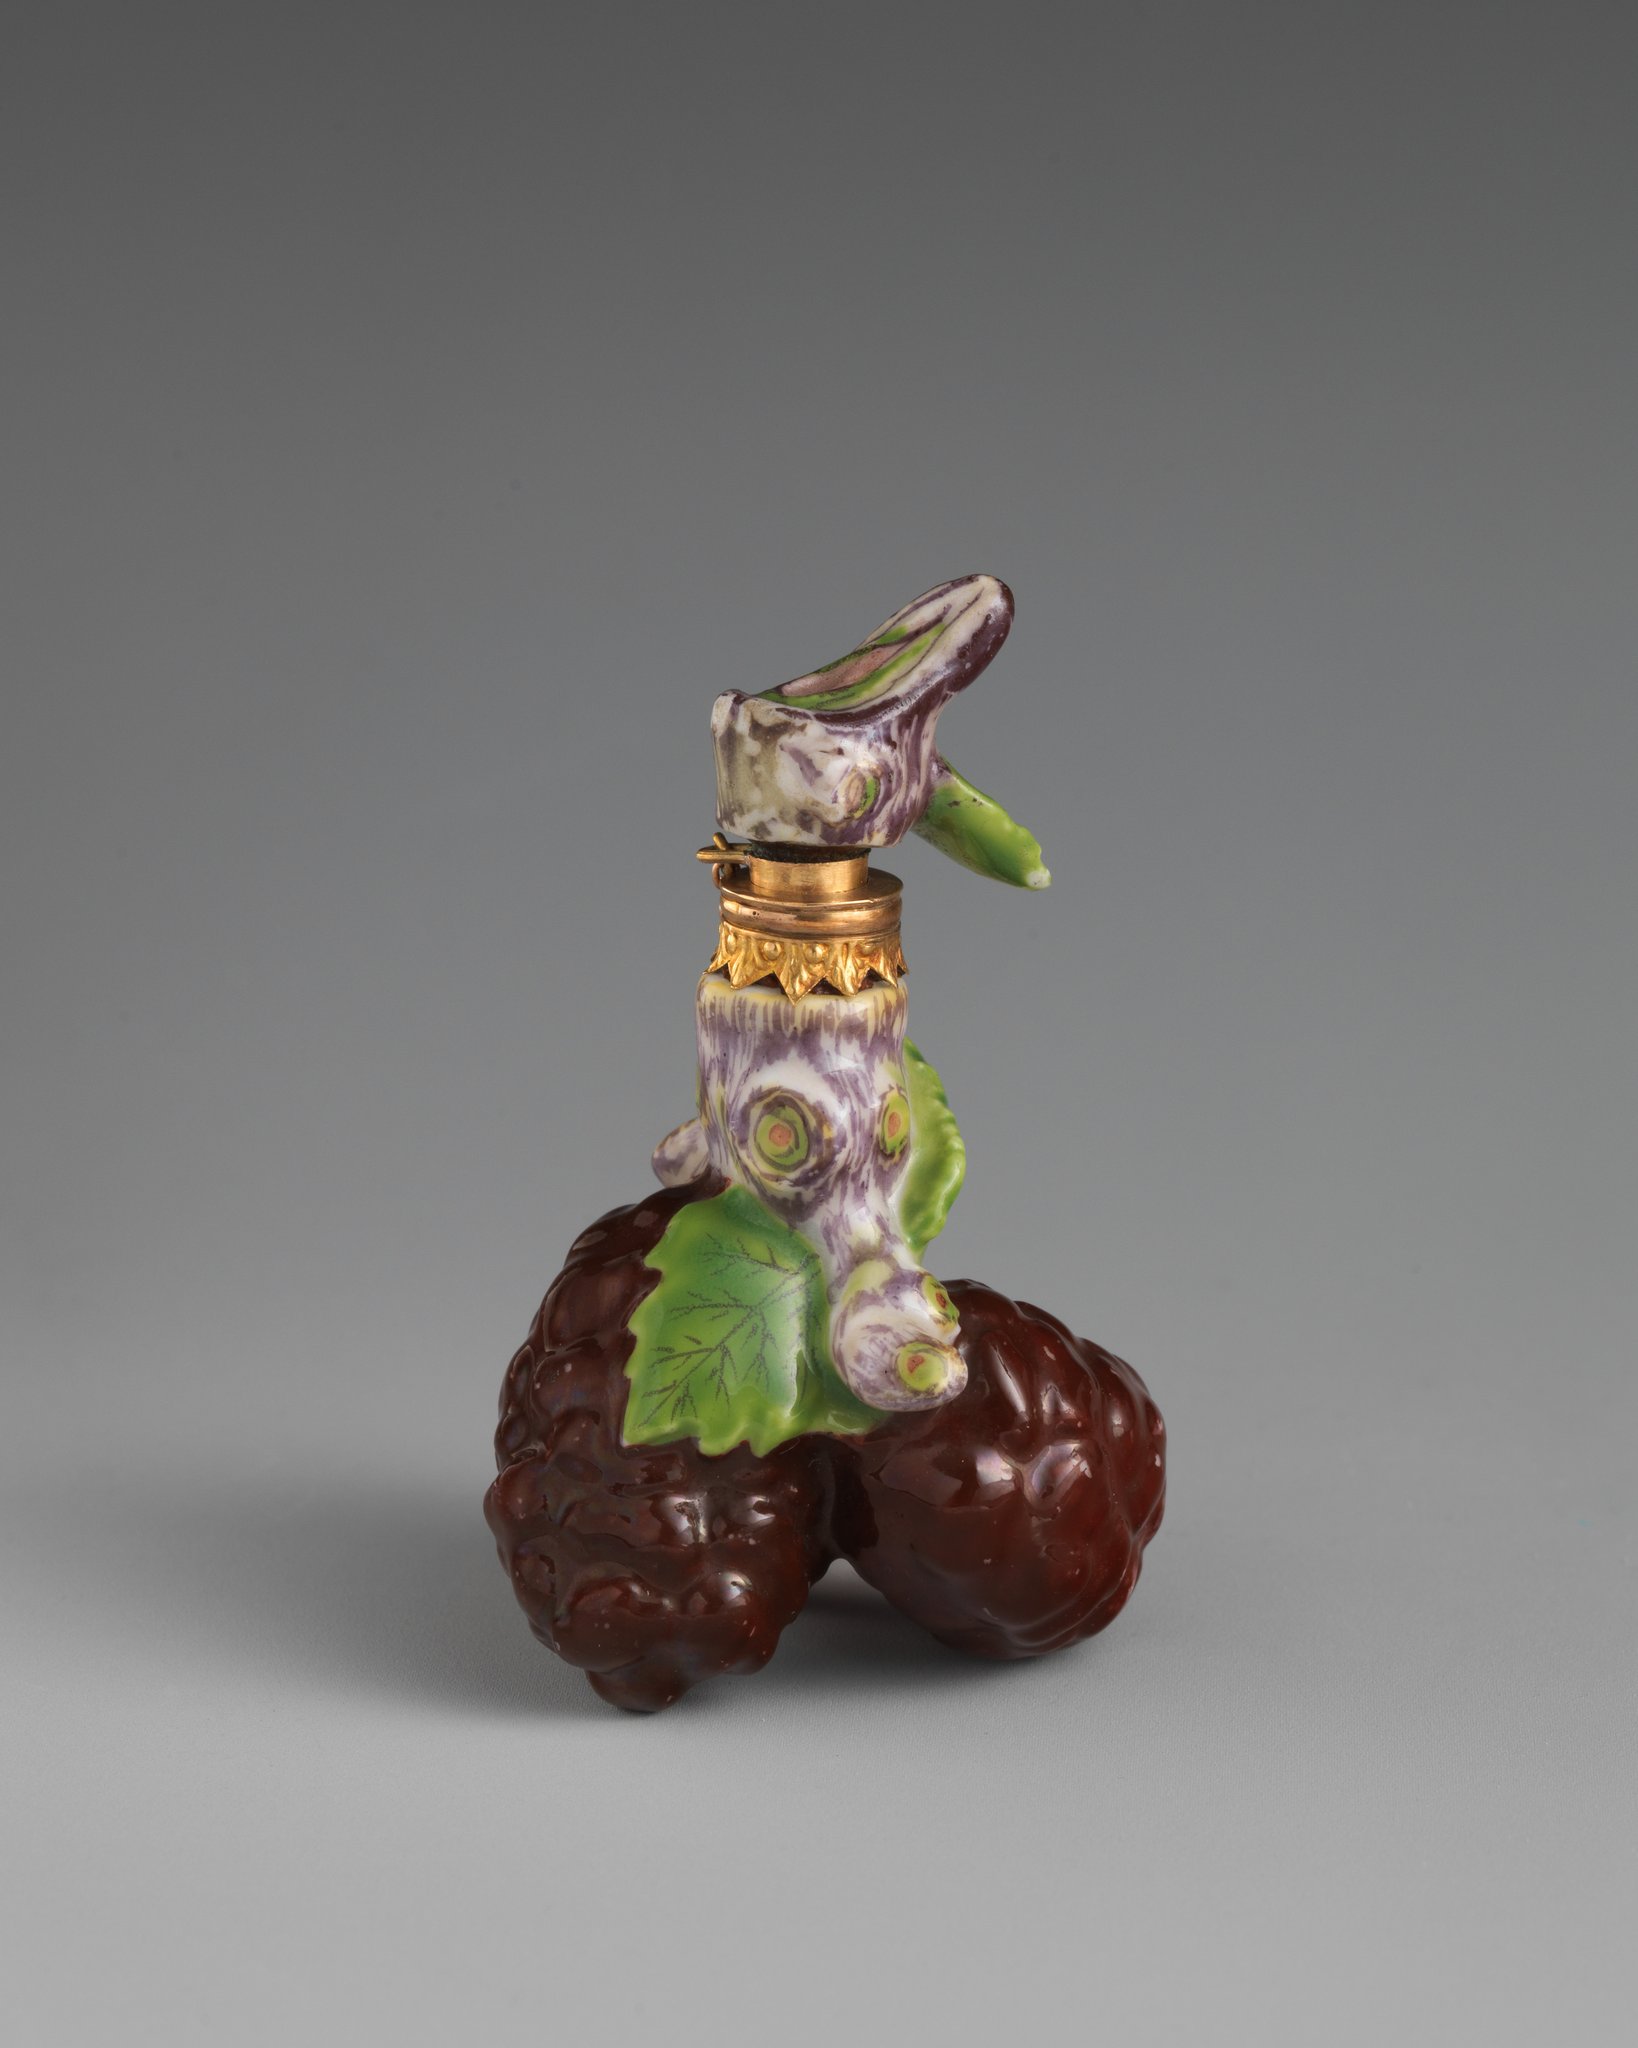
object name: toy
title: Fruit cluster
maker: chelsea porcelain manufactory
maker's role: factory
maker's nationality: british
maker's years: 1744-1784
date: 1760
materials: soft paste porcelain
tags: fruit,leaves